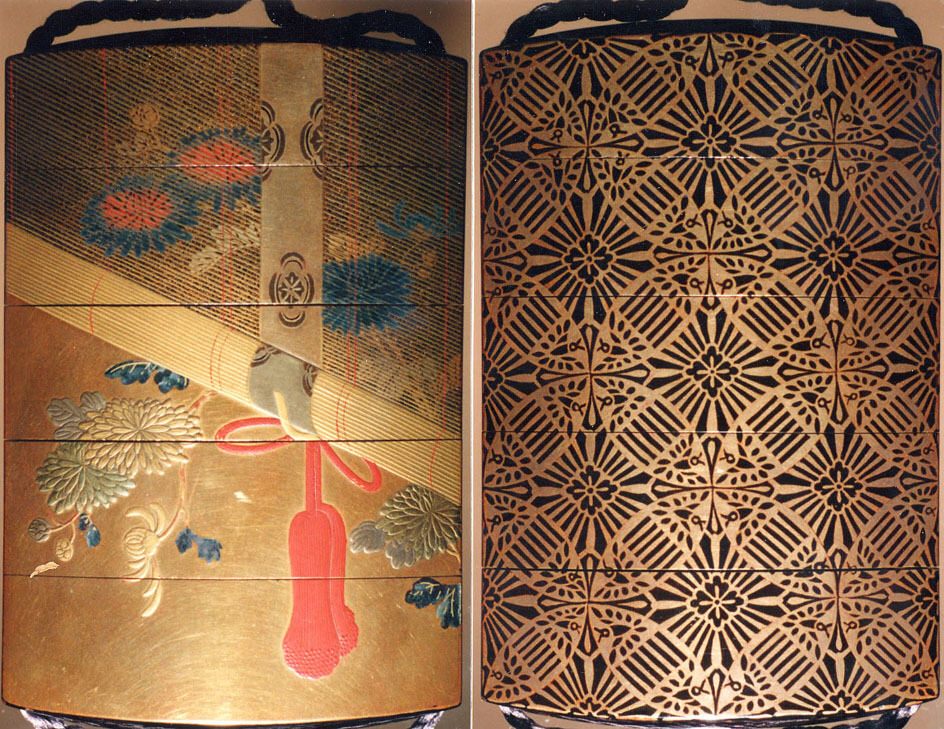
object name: inrō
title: Case (Inrō) with Design of Chrysanthemums behind Bamboo Blind (Sudare) (obverse); Brocade Pattern (reverse)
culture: japanese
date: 1801-1900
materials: gold, lacquer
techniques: fundame, hiramakie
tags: flowers